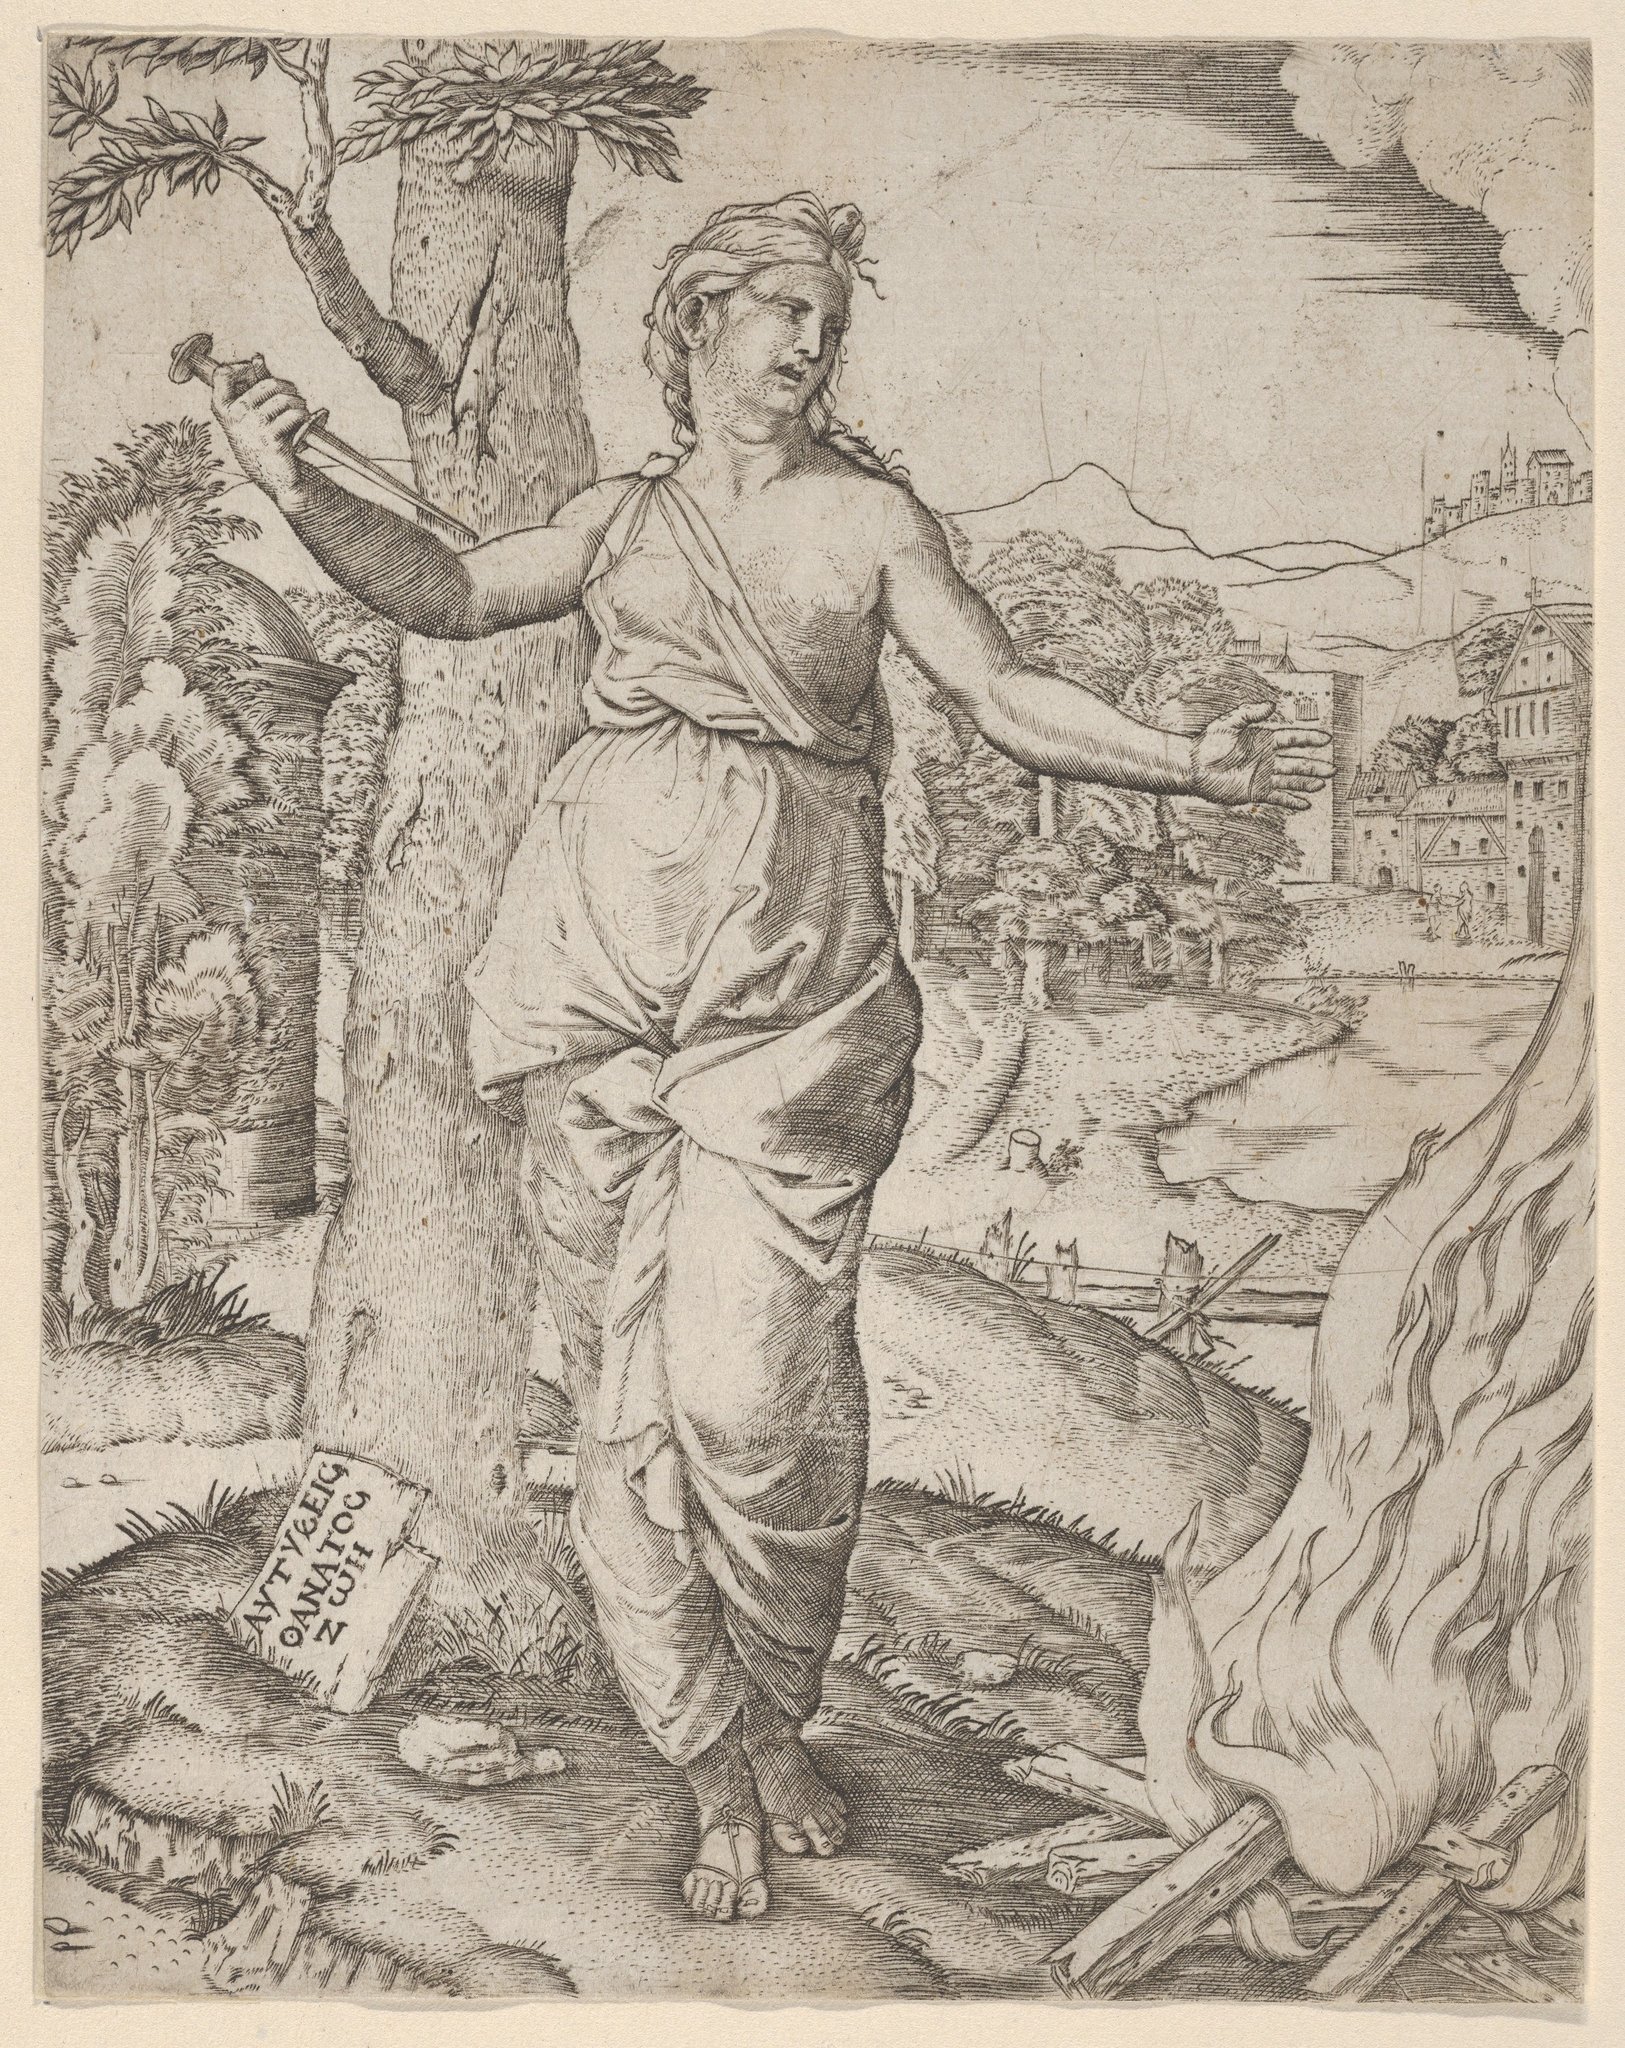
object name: print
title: Dido holding a dagger in her right hand, left arm outstreched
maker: Anonymous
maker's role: artist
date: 1510-1530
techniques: engraving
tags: daggers,women,trees